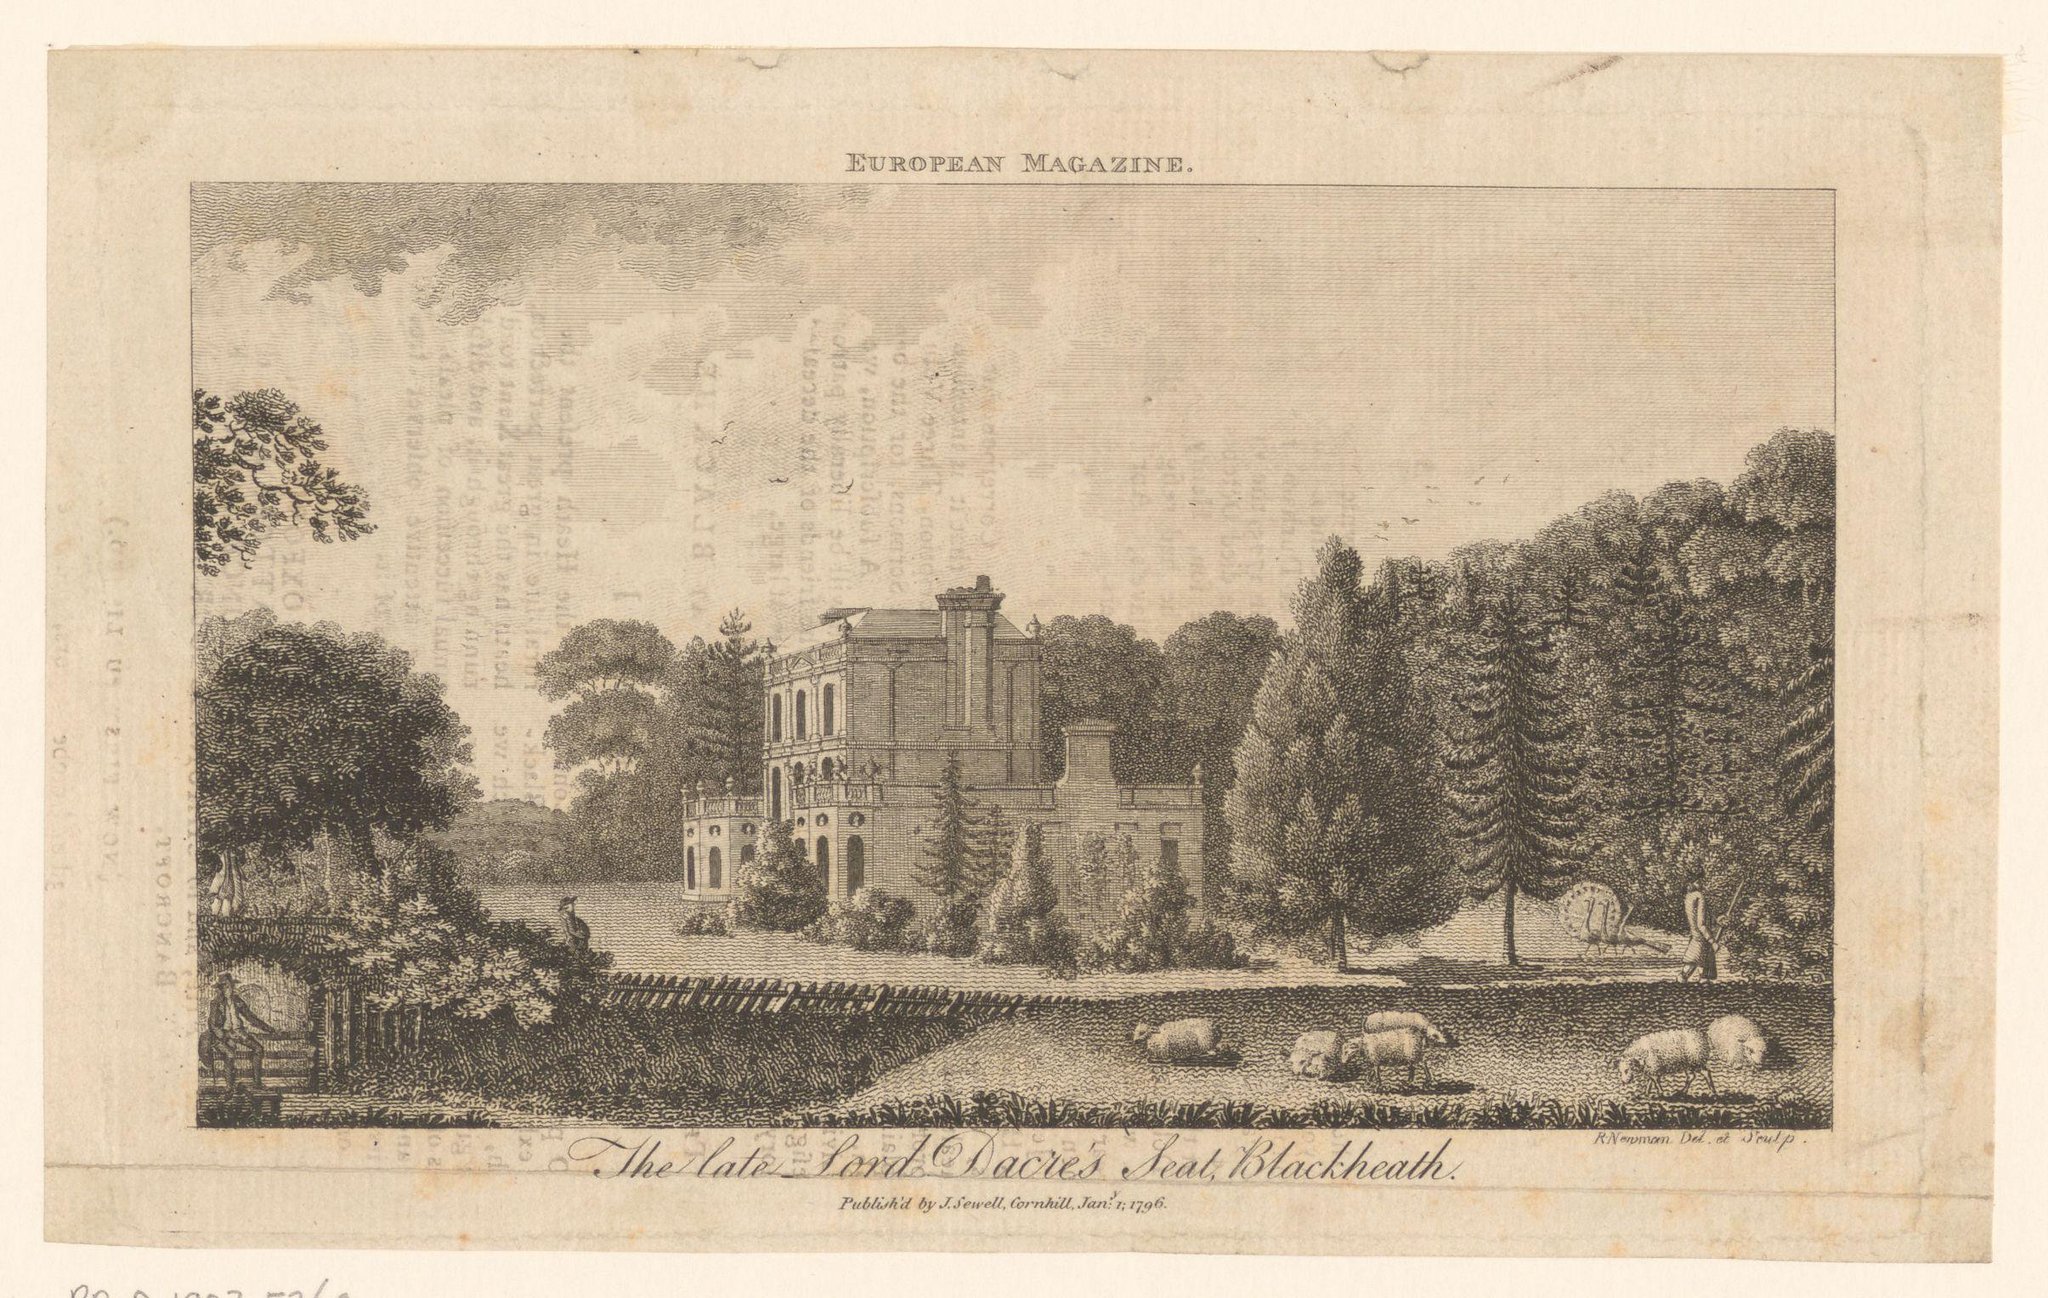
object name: print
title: Gezicht op een landhuis in Blackheath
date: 1796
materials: paper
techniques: etching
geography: london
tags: country-house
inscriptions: collector's mark: Lugt 2228